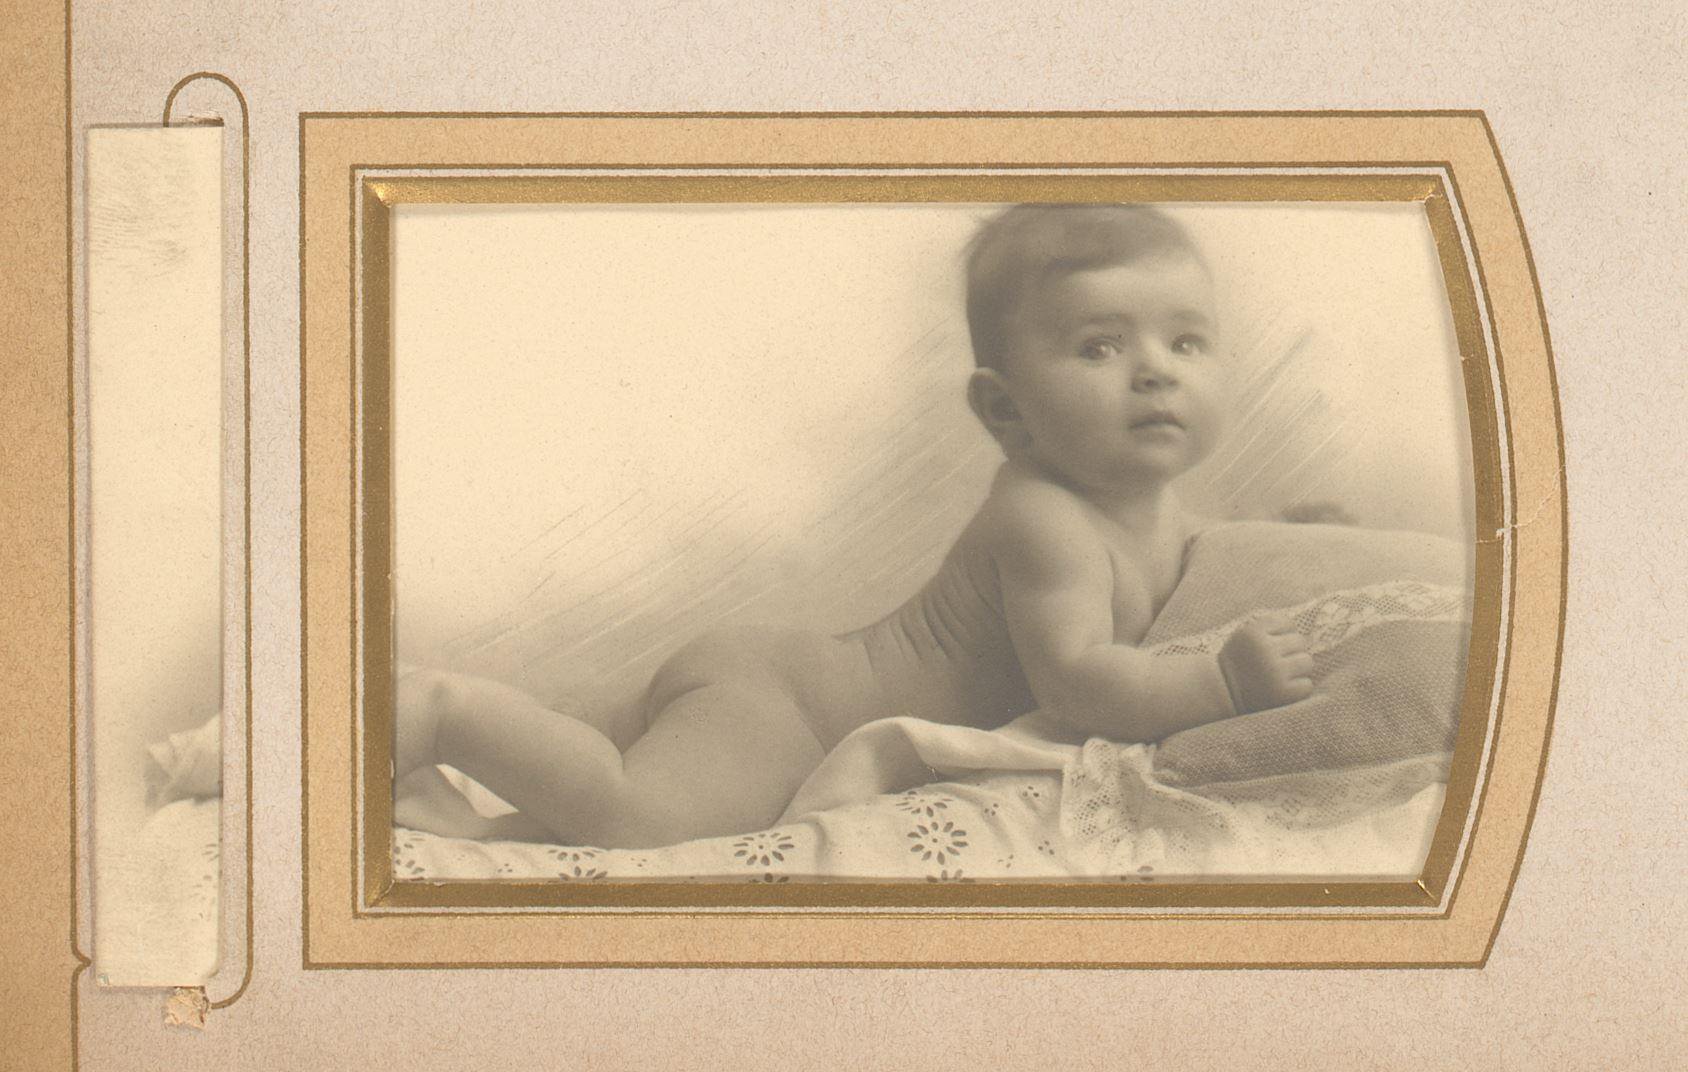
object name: photograph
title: Portret van een baby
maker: Anonymous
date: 1870-1900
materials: cardboard, photographic support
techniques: gelatin silver print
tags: historical persons, infant, baby